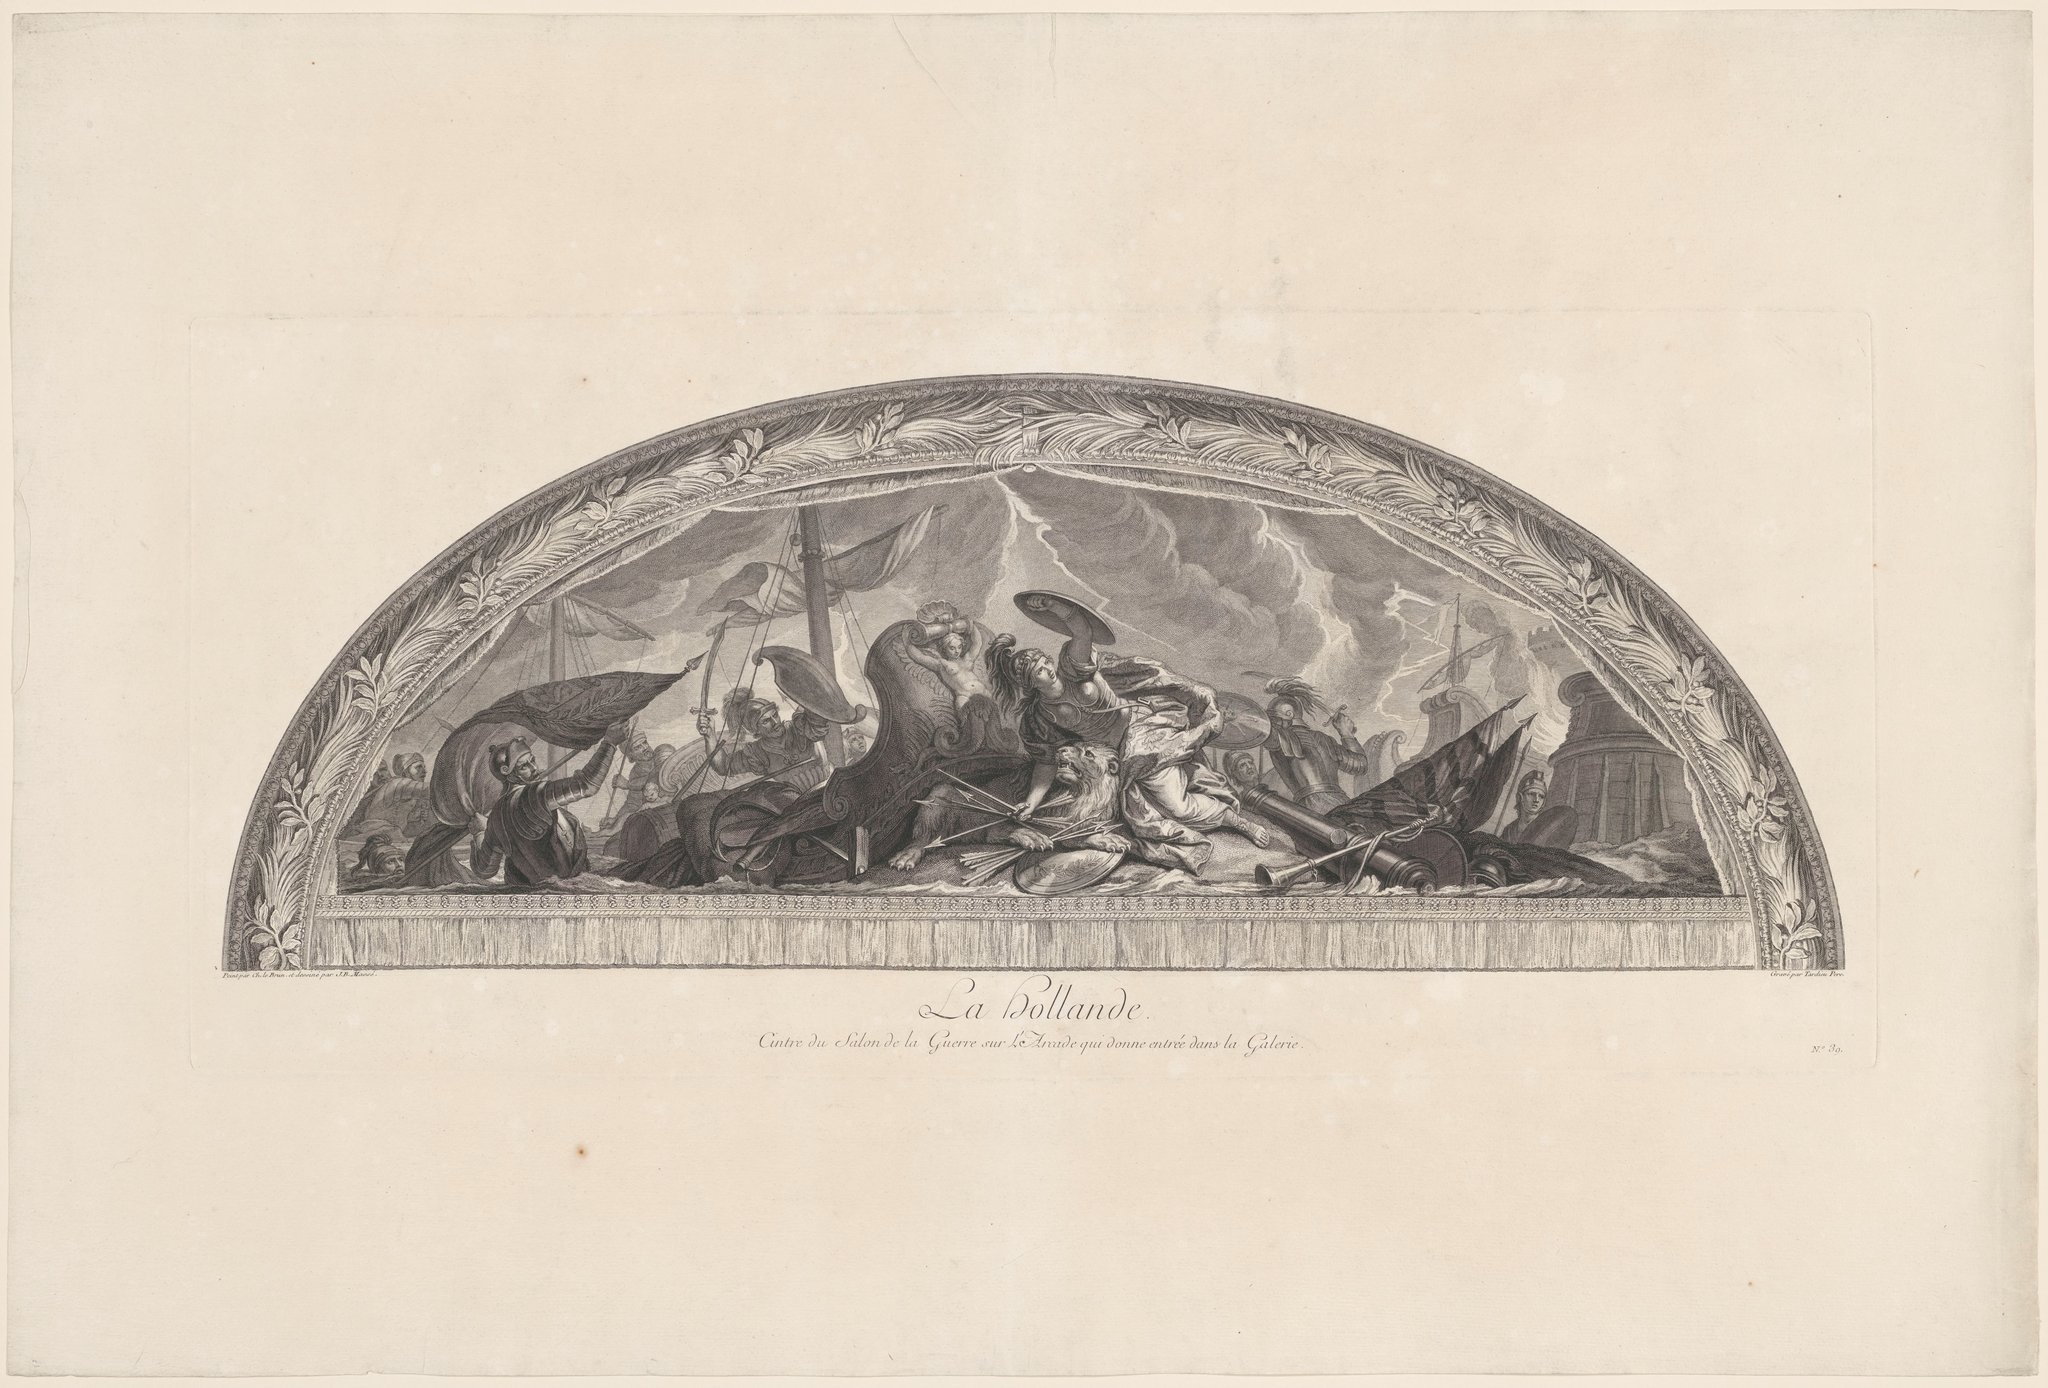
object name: print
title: L'ouvrage de Charles le Brun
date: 1752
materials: paper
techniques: engraving, etching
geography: france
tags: personifications of countries, nations, states, districts, etc., battle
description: Prent uit: Massé, Jean Baptiste. La Grande Galerie de Versailles, et les deux salons qui l'accompagnent, peints par Charles le Brun premier peintre de Louis XIV, dessinés par Jean- Baptiste Masse peintre et conseiller de l'Academie royale de peinture & sculpture; et gravés sous ses yeux par les meilleurs maitres du tems. Parijs: Imprimerie Royale, 1752.